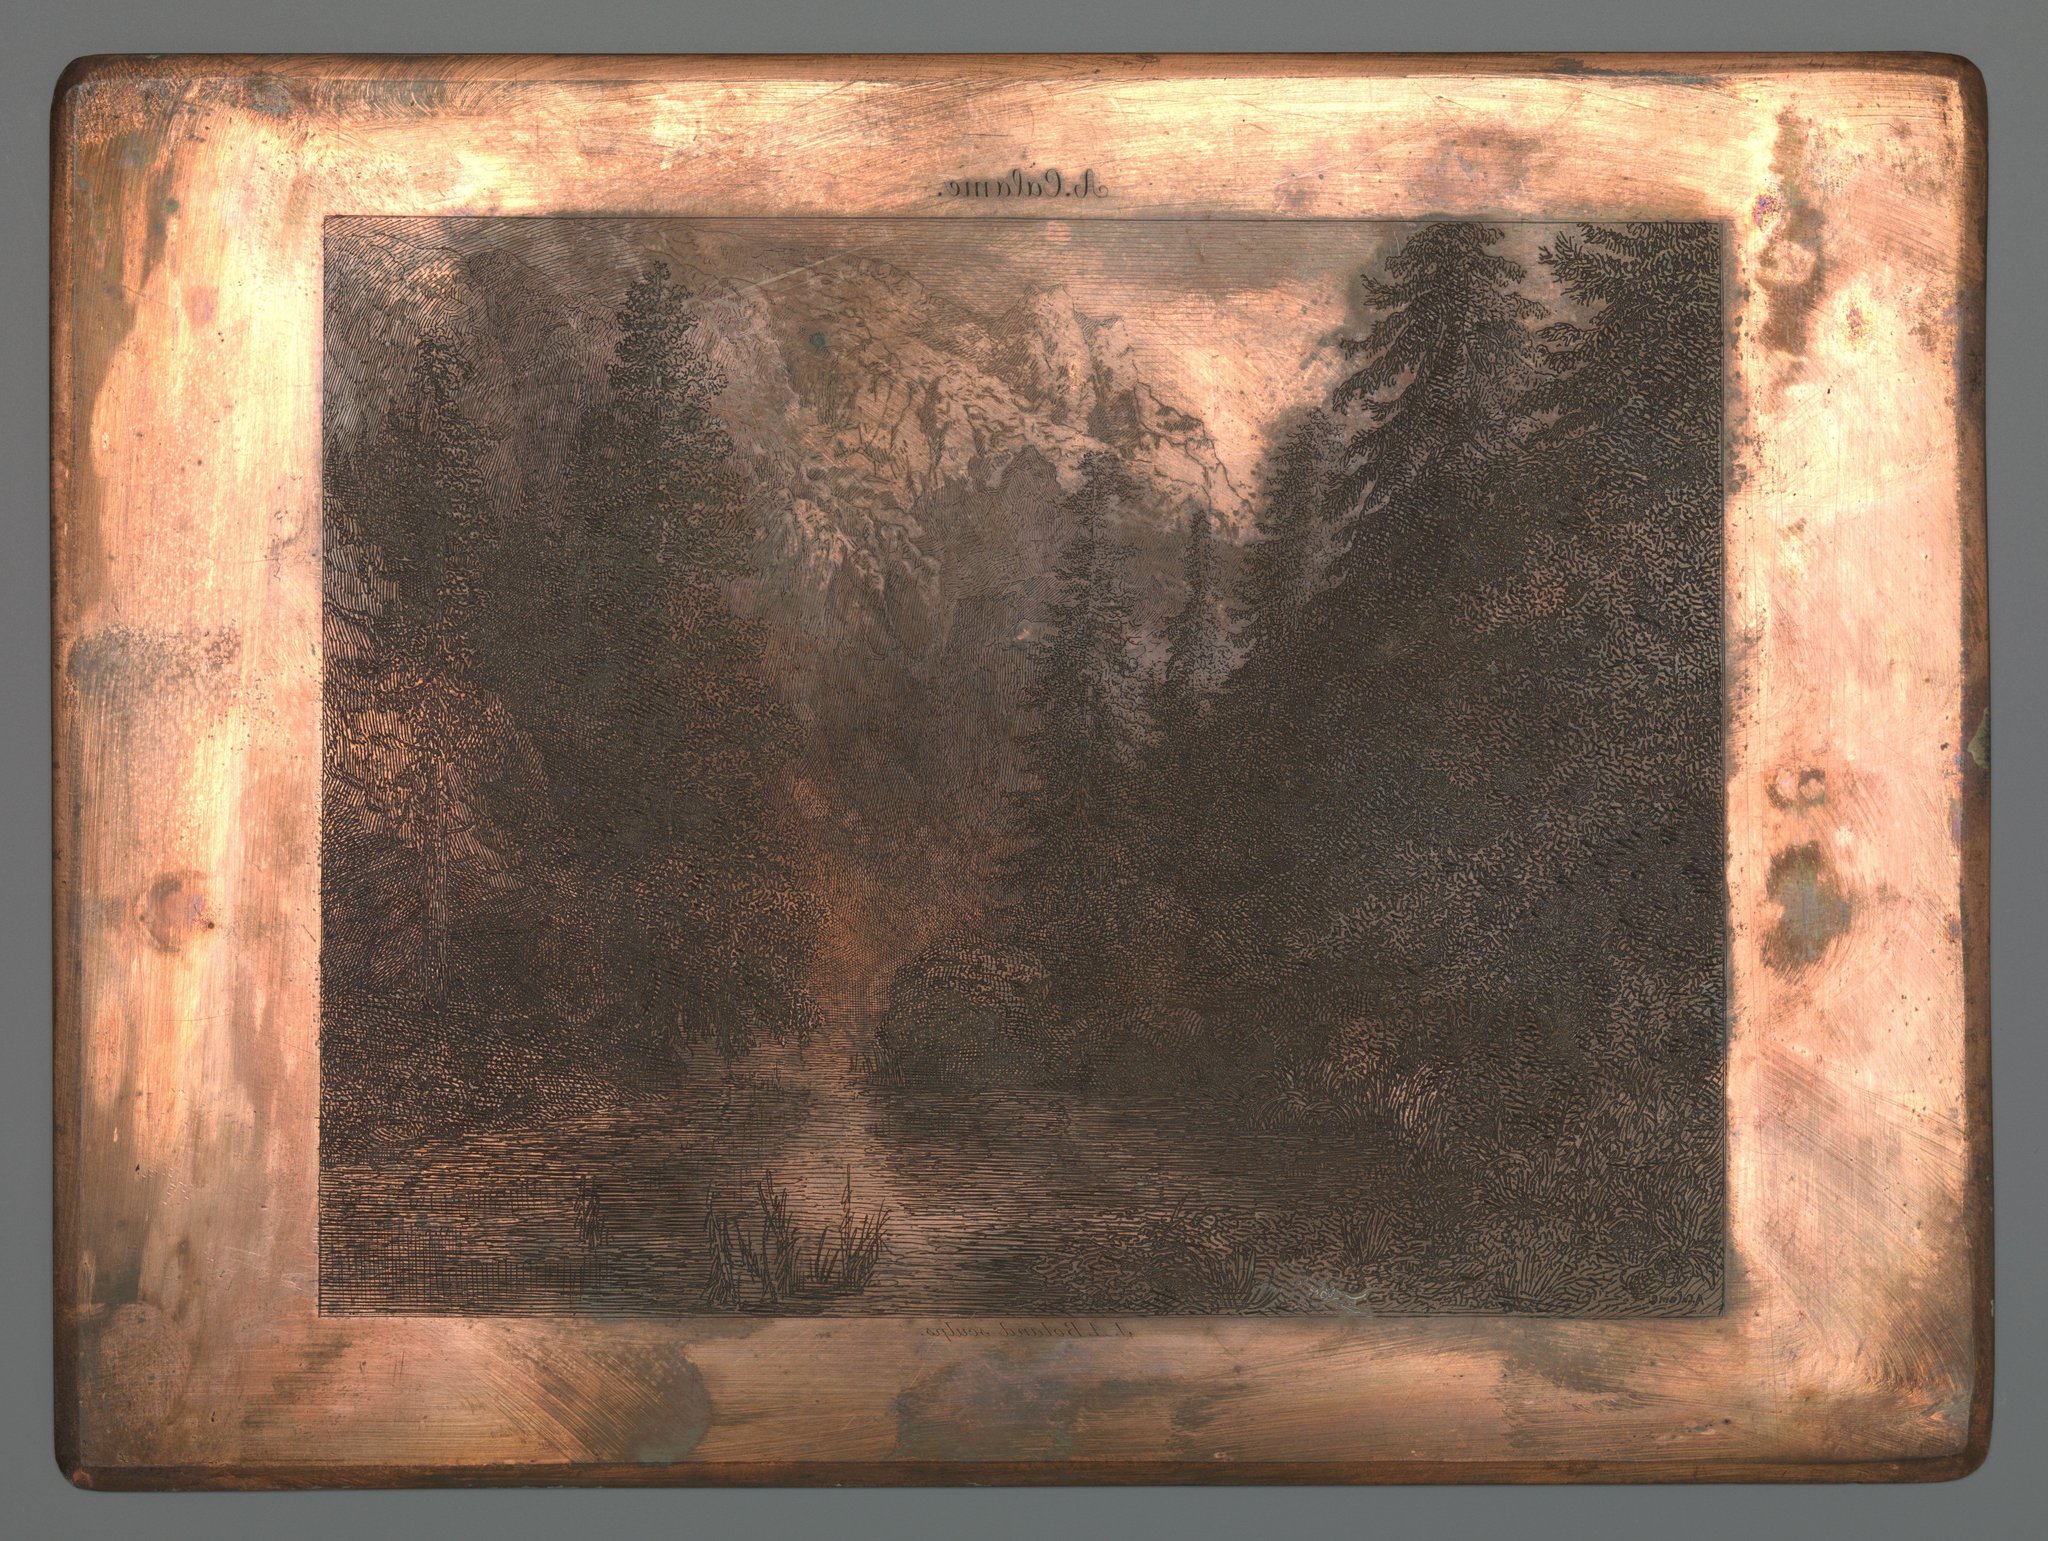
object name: copper plate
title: Bergrivier tussen bomen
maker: johannes arnoldus boland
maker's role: print maker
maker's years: 1838-1922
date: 1848-1909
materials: copper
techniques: etching